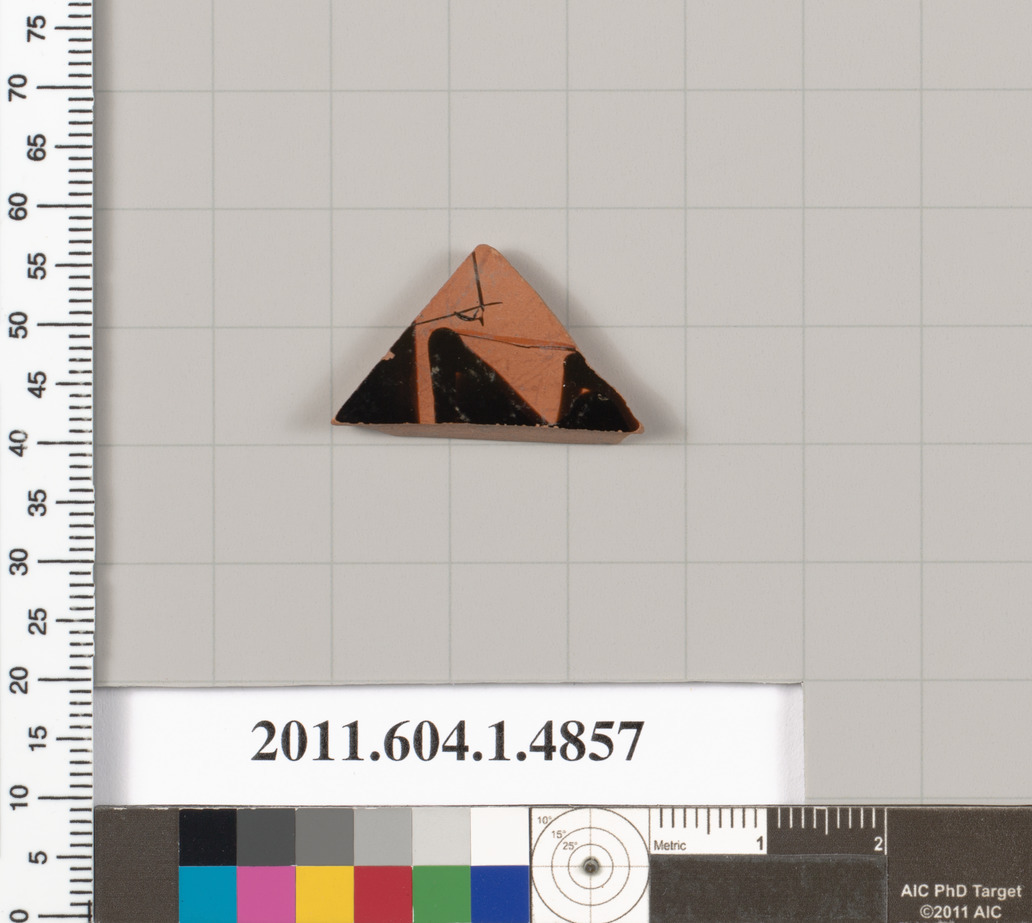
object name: kylix fragment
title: Terracotta fragment of a kylix (drinking cup)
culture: greek, attic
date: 467-435 BCE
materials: terracotta